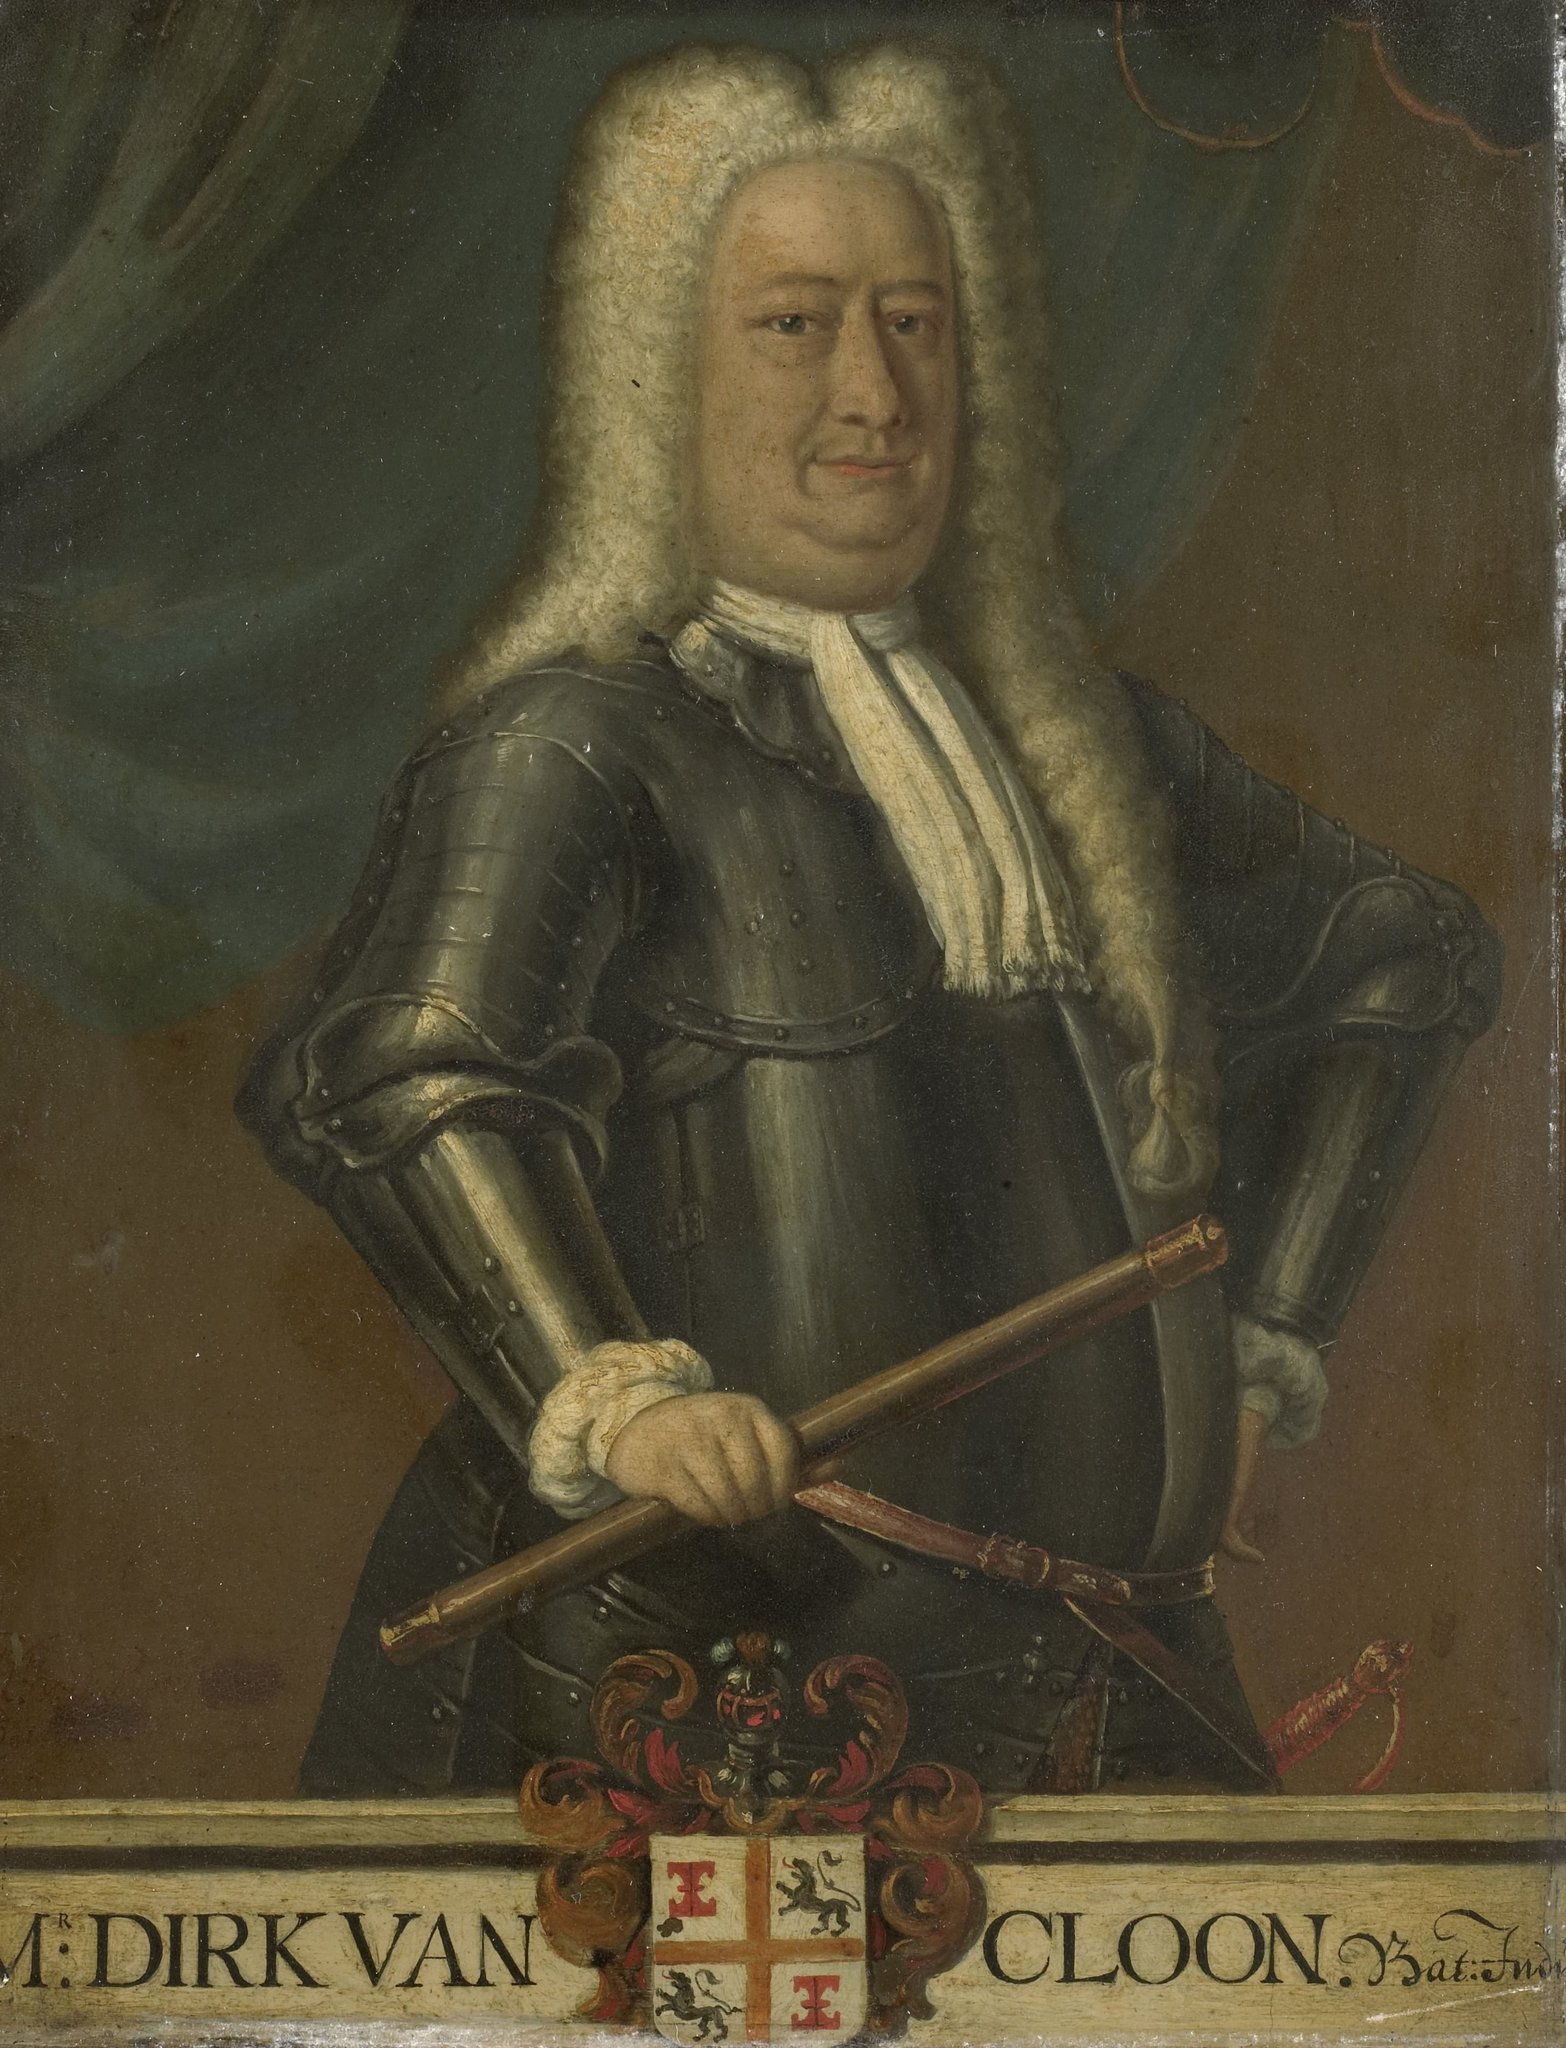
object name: painting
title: Portrait of Dirk van Cloon, Governor-General of the Dutch East Indies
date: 1750-1799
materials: copper, oil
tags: batavia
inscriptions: inscription: ‘Mr. Dirj van Cloon. Bat. Ind.’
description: Portret van Dirk van Cloon (1688-1735). Gouverneur-generaal (1730-35). Staande, ten halven lijve naar rechts, in wapenrusting. Commandostaf in de rechterhand, de linkerhand in de zij. Onderdeel van een reeks van kopieën naar portretten van de gouverneurs-generaal van het voormalige Nederlands Oost-Indië, waarschijnlijk afkomstig van de Verenigde Oostindische Compagnie. Vrije kopie naar SK-A-3776.